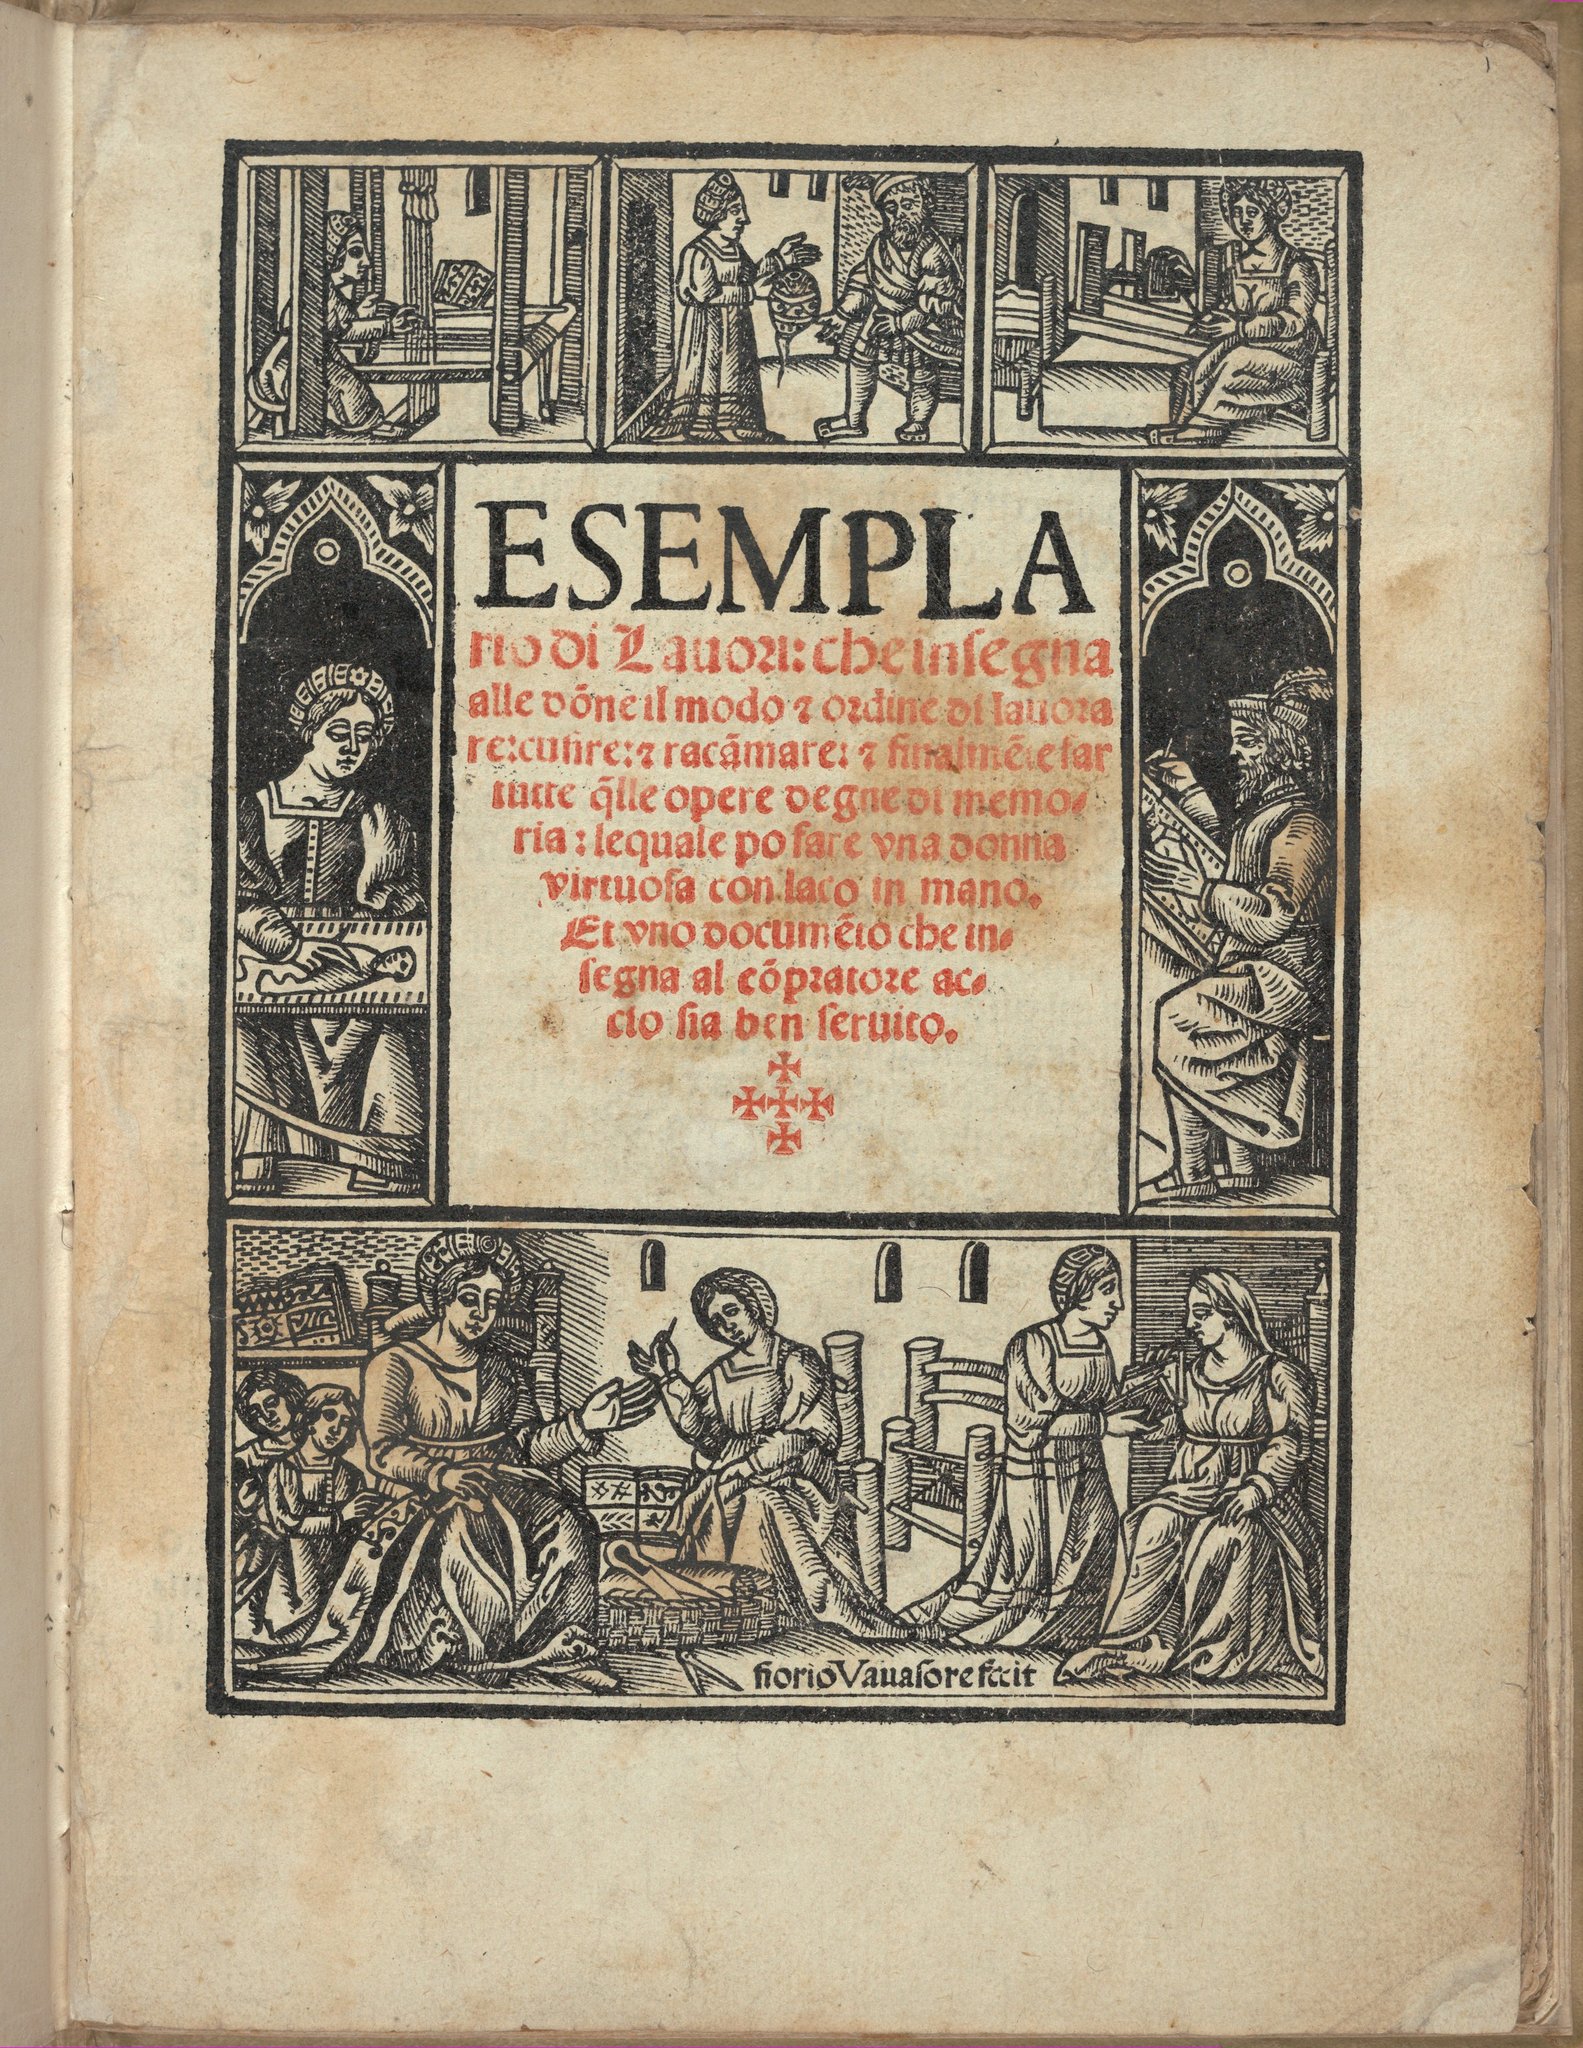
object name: book print ornament architecture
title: Esemplario di Lauori..., title page (recto)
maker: giovanni andrea vavassore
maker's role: publisher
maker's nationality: italian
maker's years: 1530-1573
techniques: woodcut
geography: venice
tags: men,women